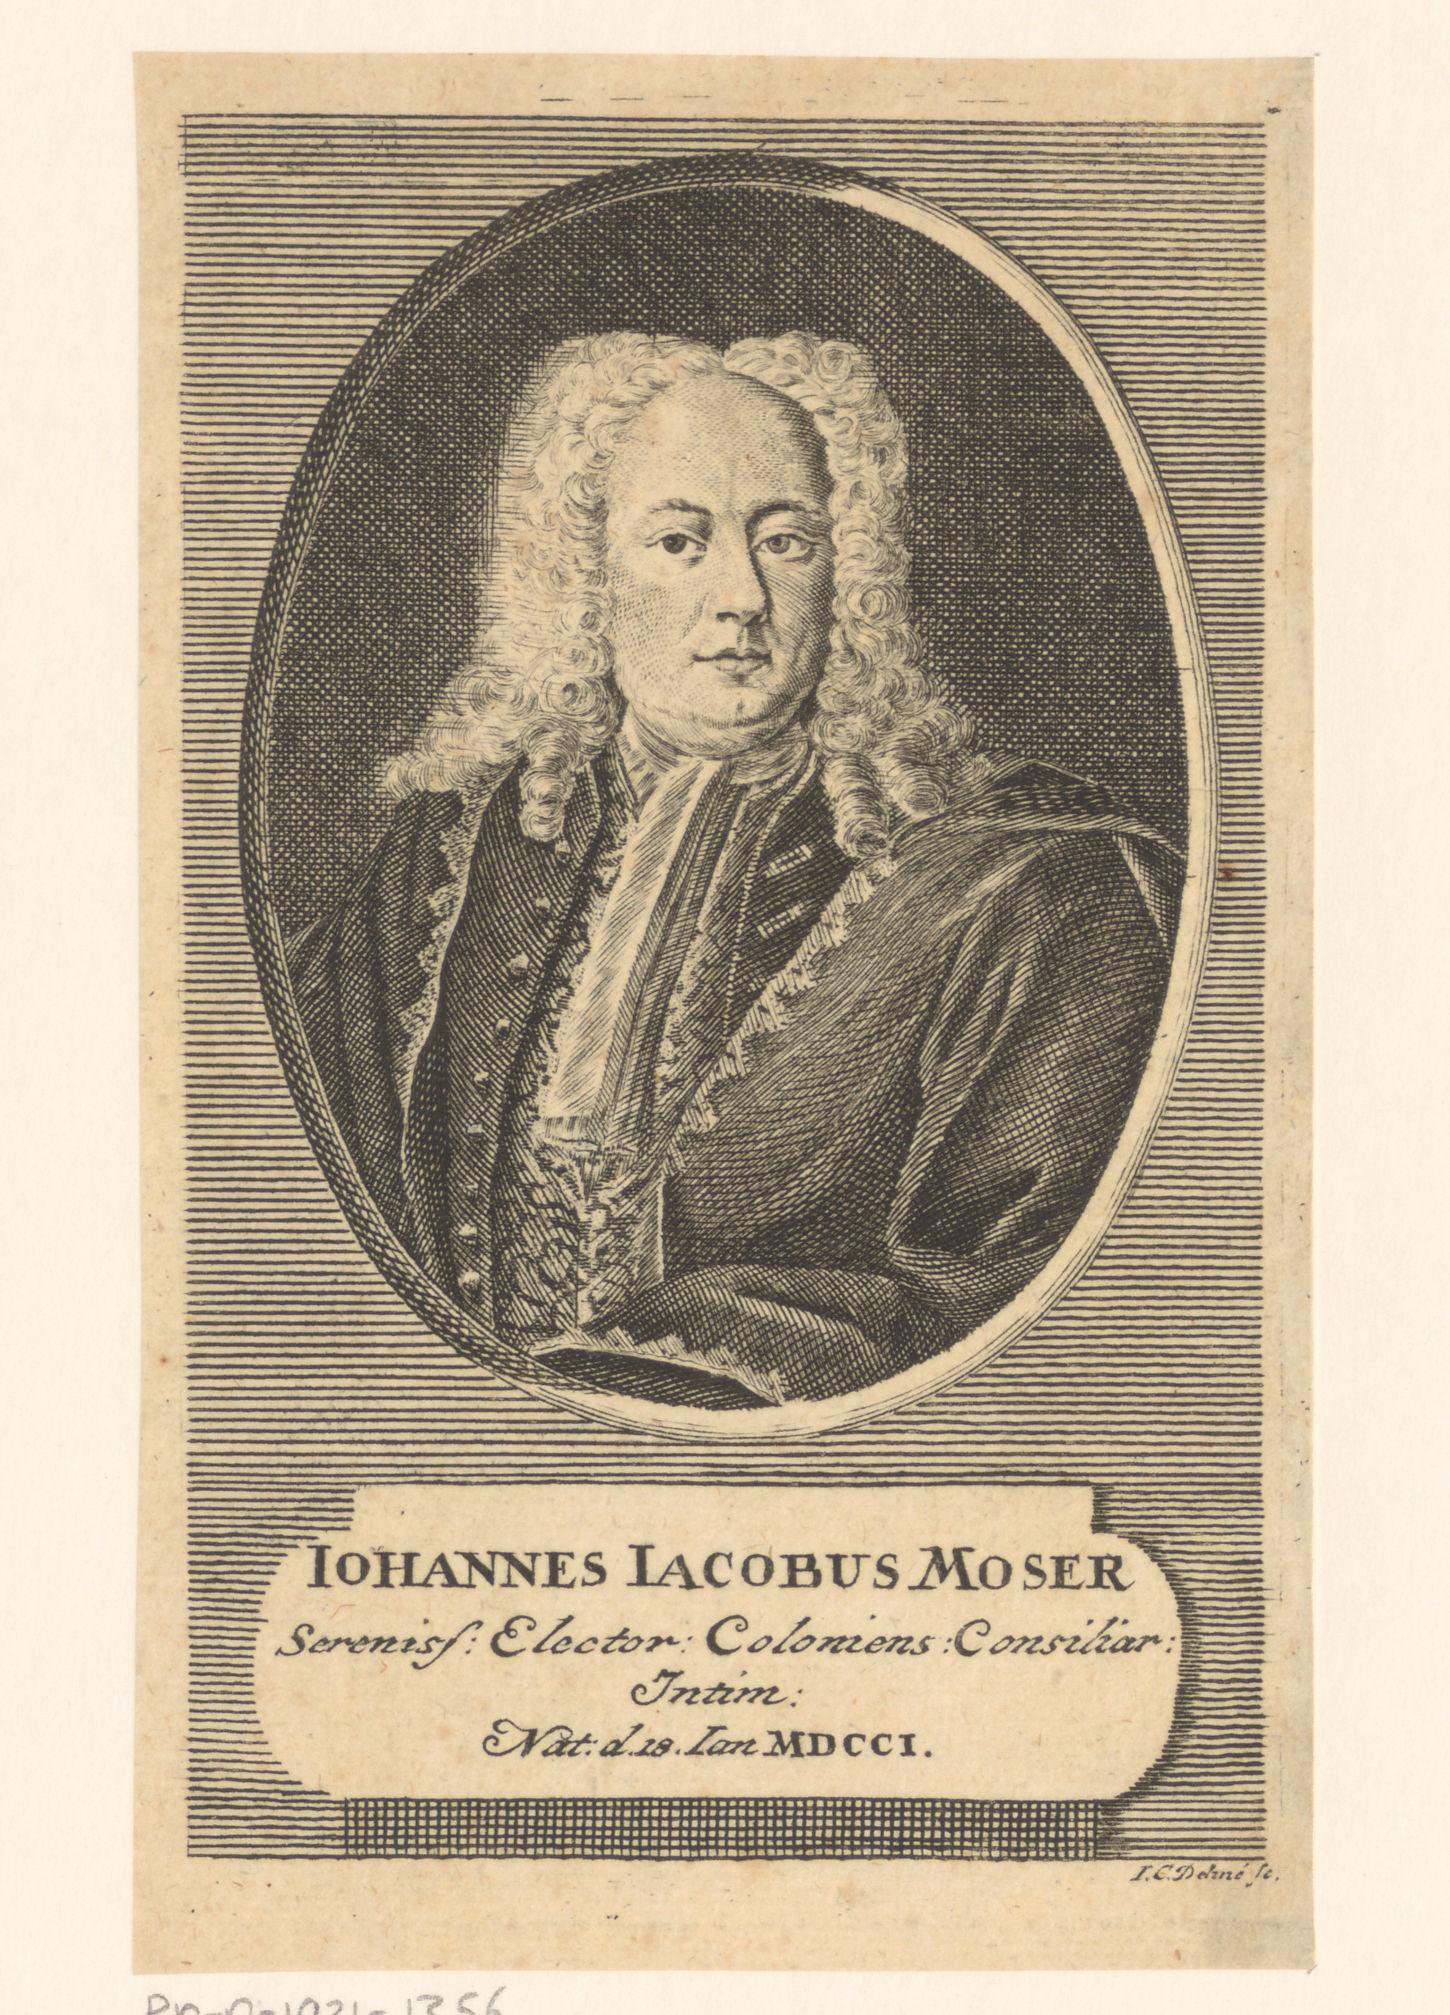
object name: print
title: Johannes Jacobus Moser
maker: johann christoph dehne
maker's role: print maker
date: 1714-1726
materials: paper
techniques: engraving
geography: leipzig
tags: politician, historical persons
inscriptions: collector's mark: Lugt 2233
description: Prent uit: Moser, Johann Jacob. Einleitung zu dem Reichs-Hof-Raths-Process. 4 dln. Frankfurt en Leipzig: Johann Stein, 1734, dl. 1.